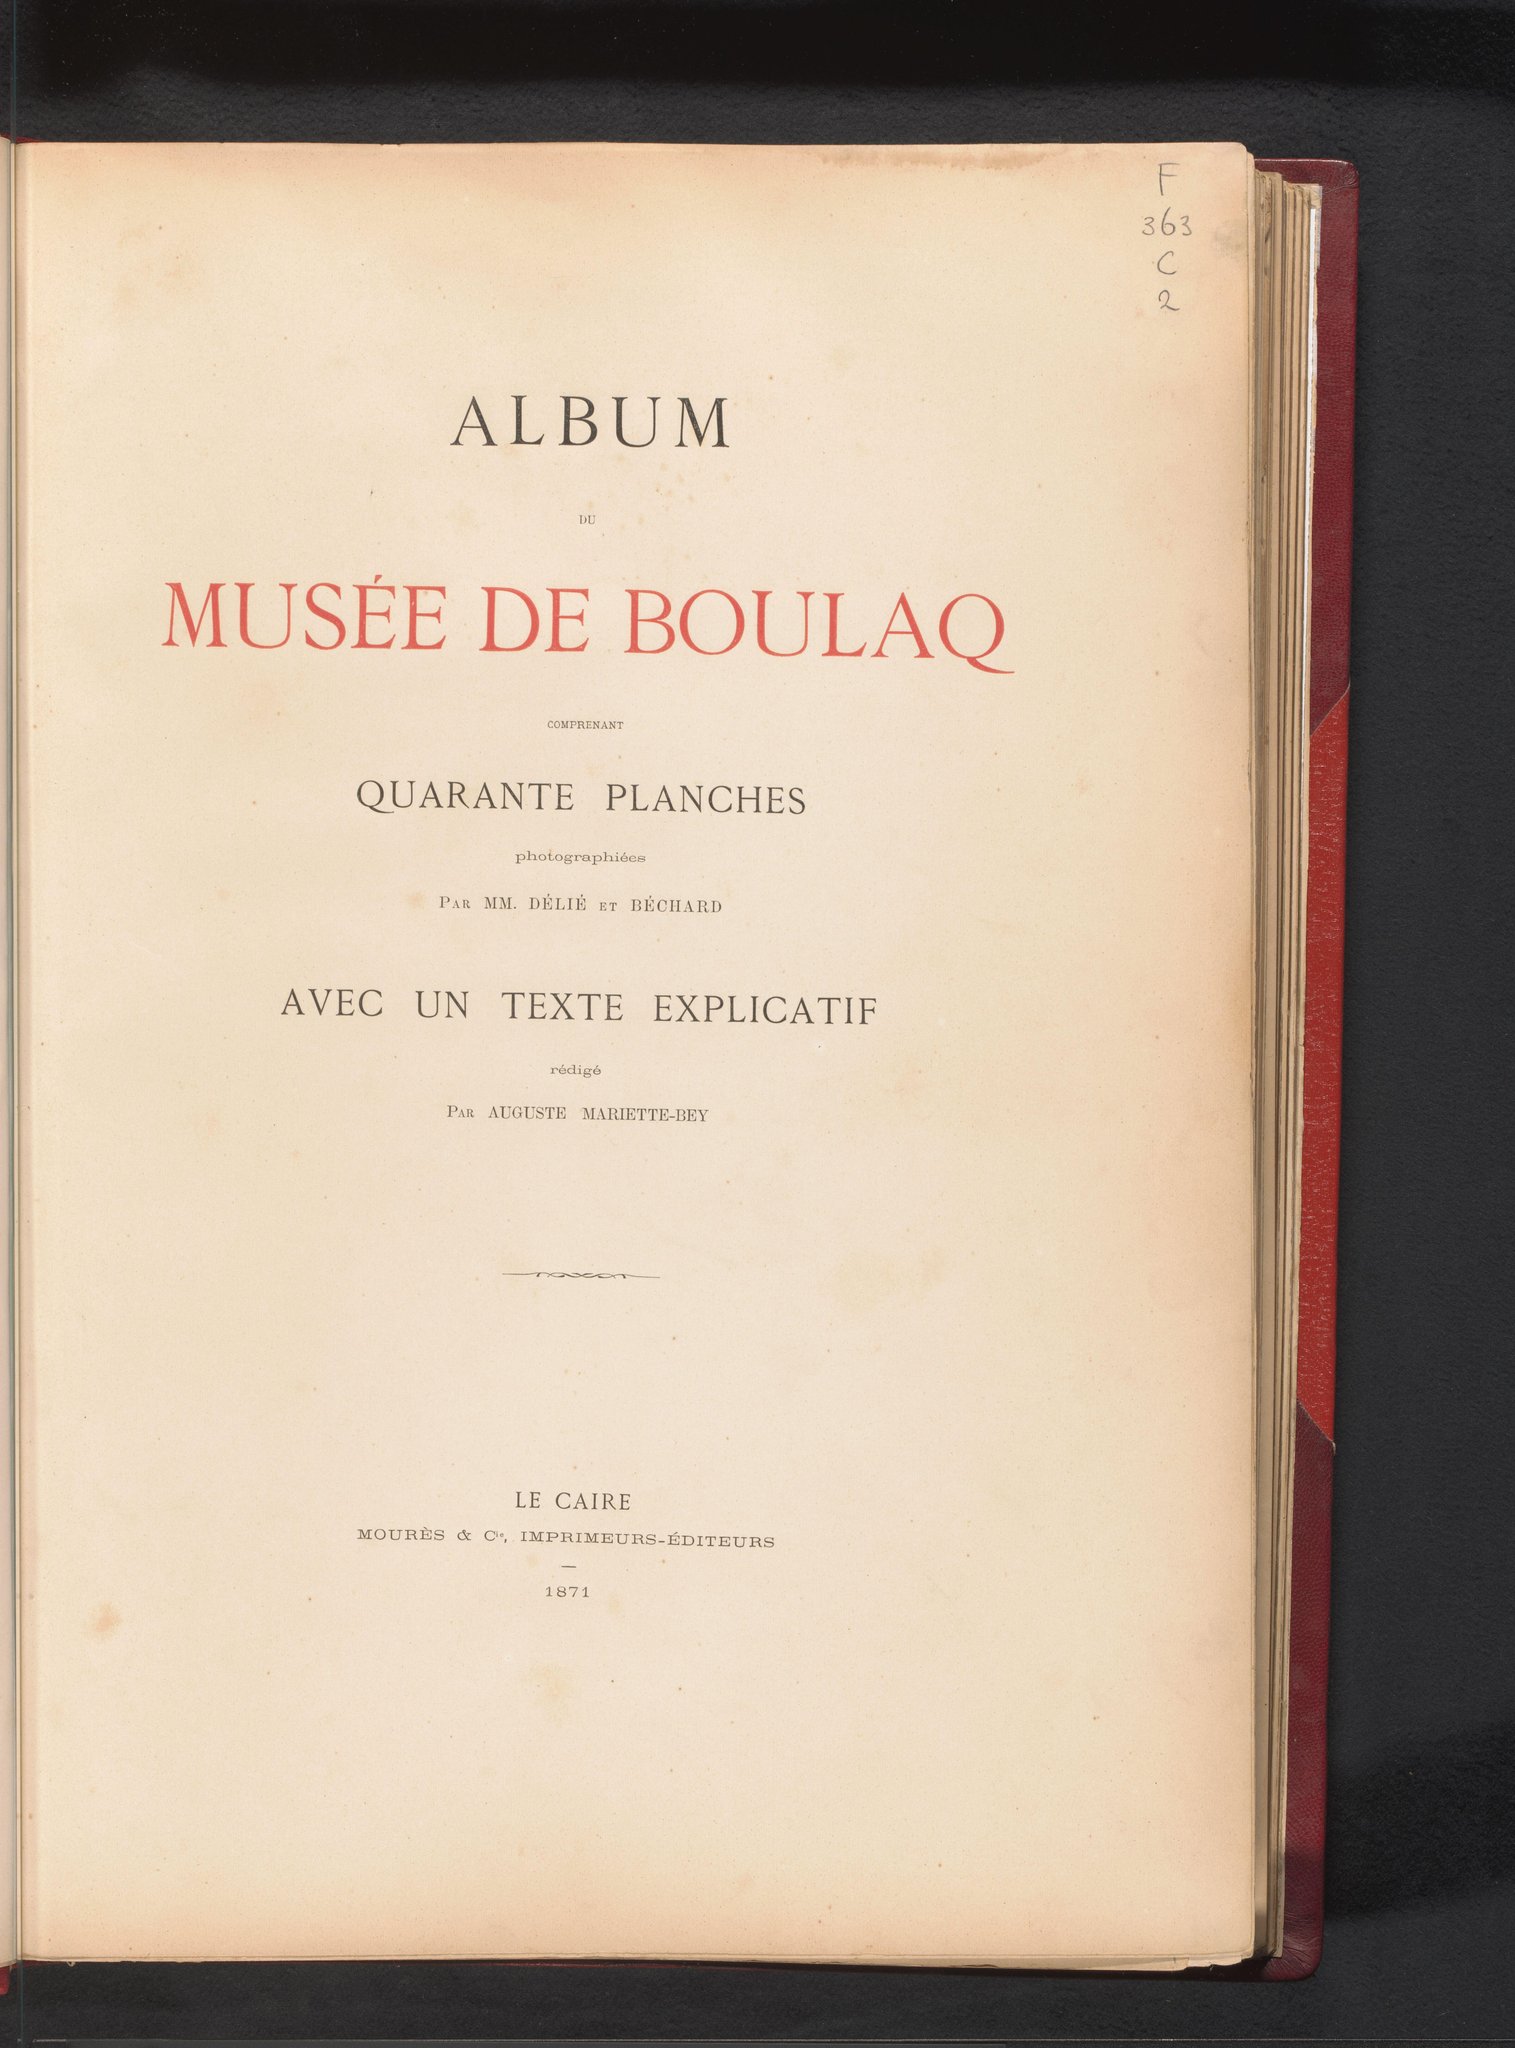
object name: book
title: Album du Musée de Boulaq / comprenant quarante planches photogr. par Délié et Béchard; avec un texte explicatif rédigé par Auguste Mariette-Bey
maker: auguste mariette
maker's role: archeoloog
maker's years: 1821-1881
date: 1871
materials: cardboard, leather, linen, paper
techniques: photograph, printing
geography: cairo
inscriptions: date: ‘JUNE/ 1995’